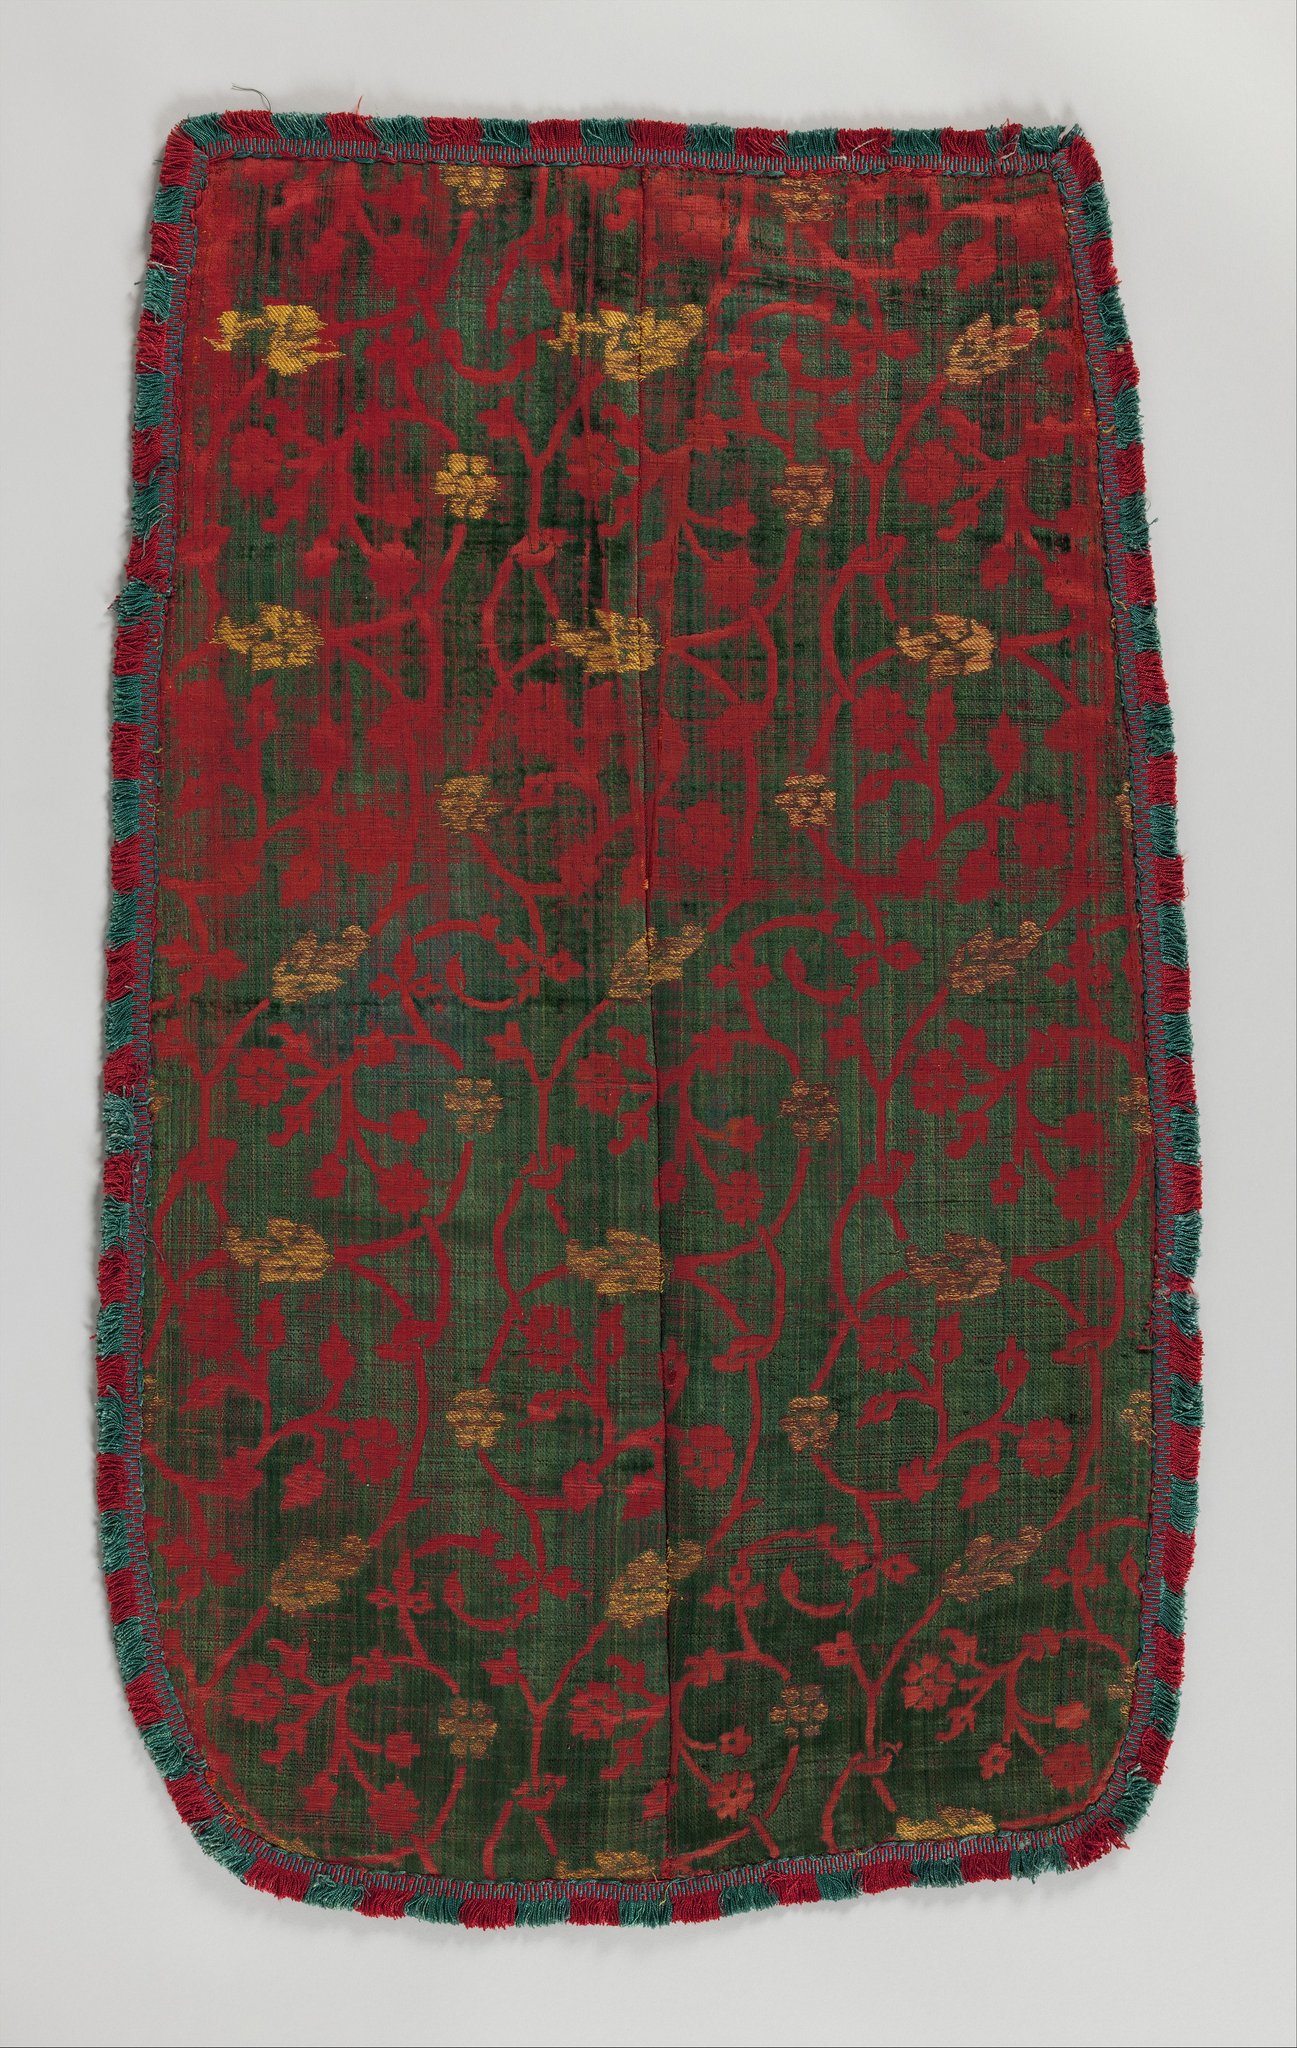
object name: panel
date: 1500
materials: linen, metal thread, silk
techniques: lining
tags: flowers